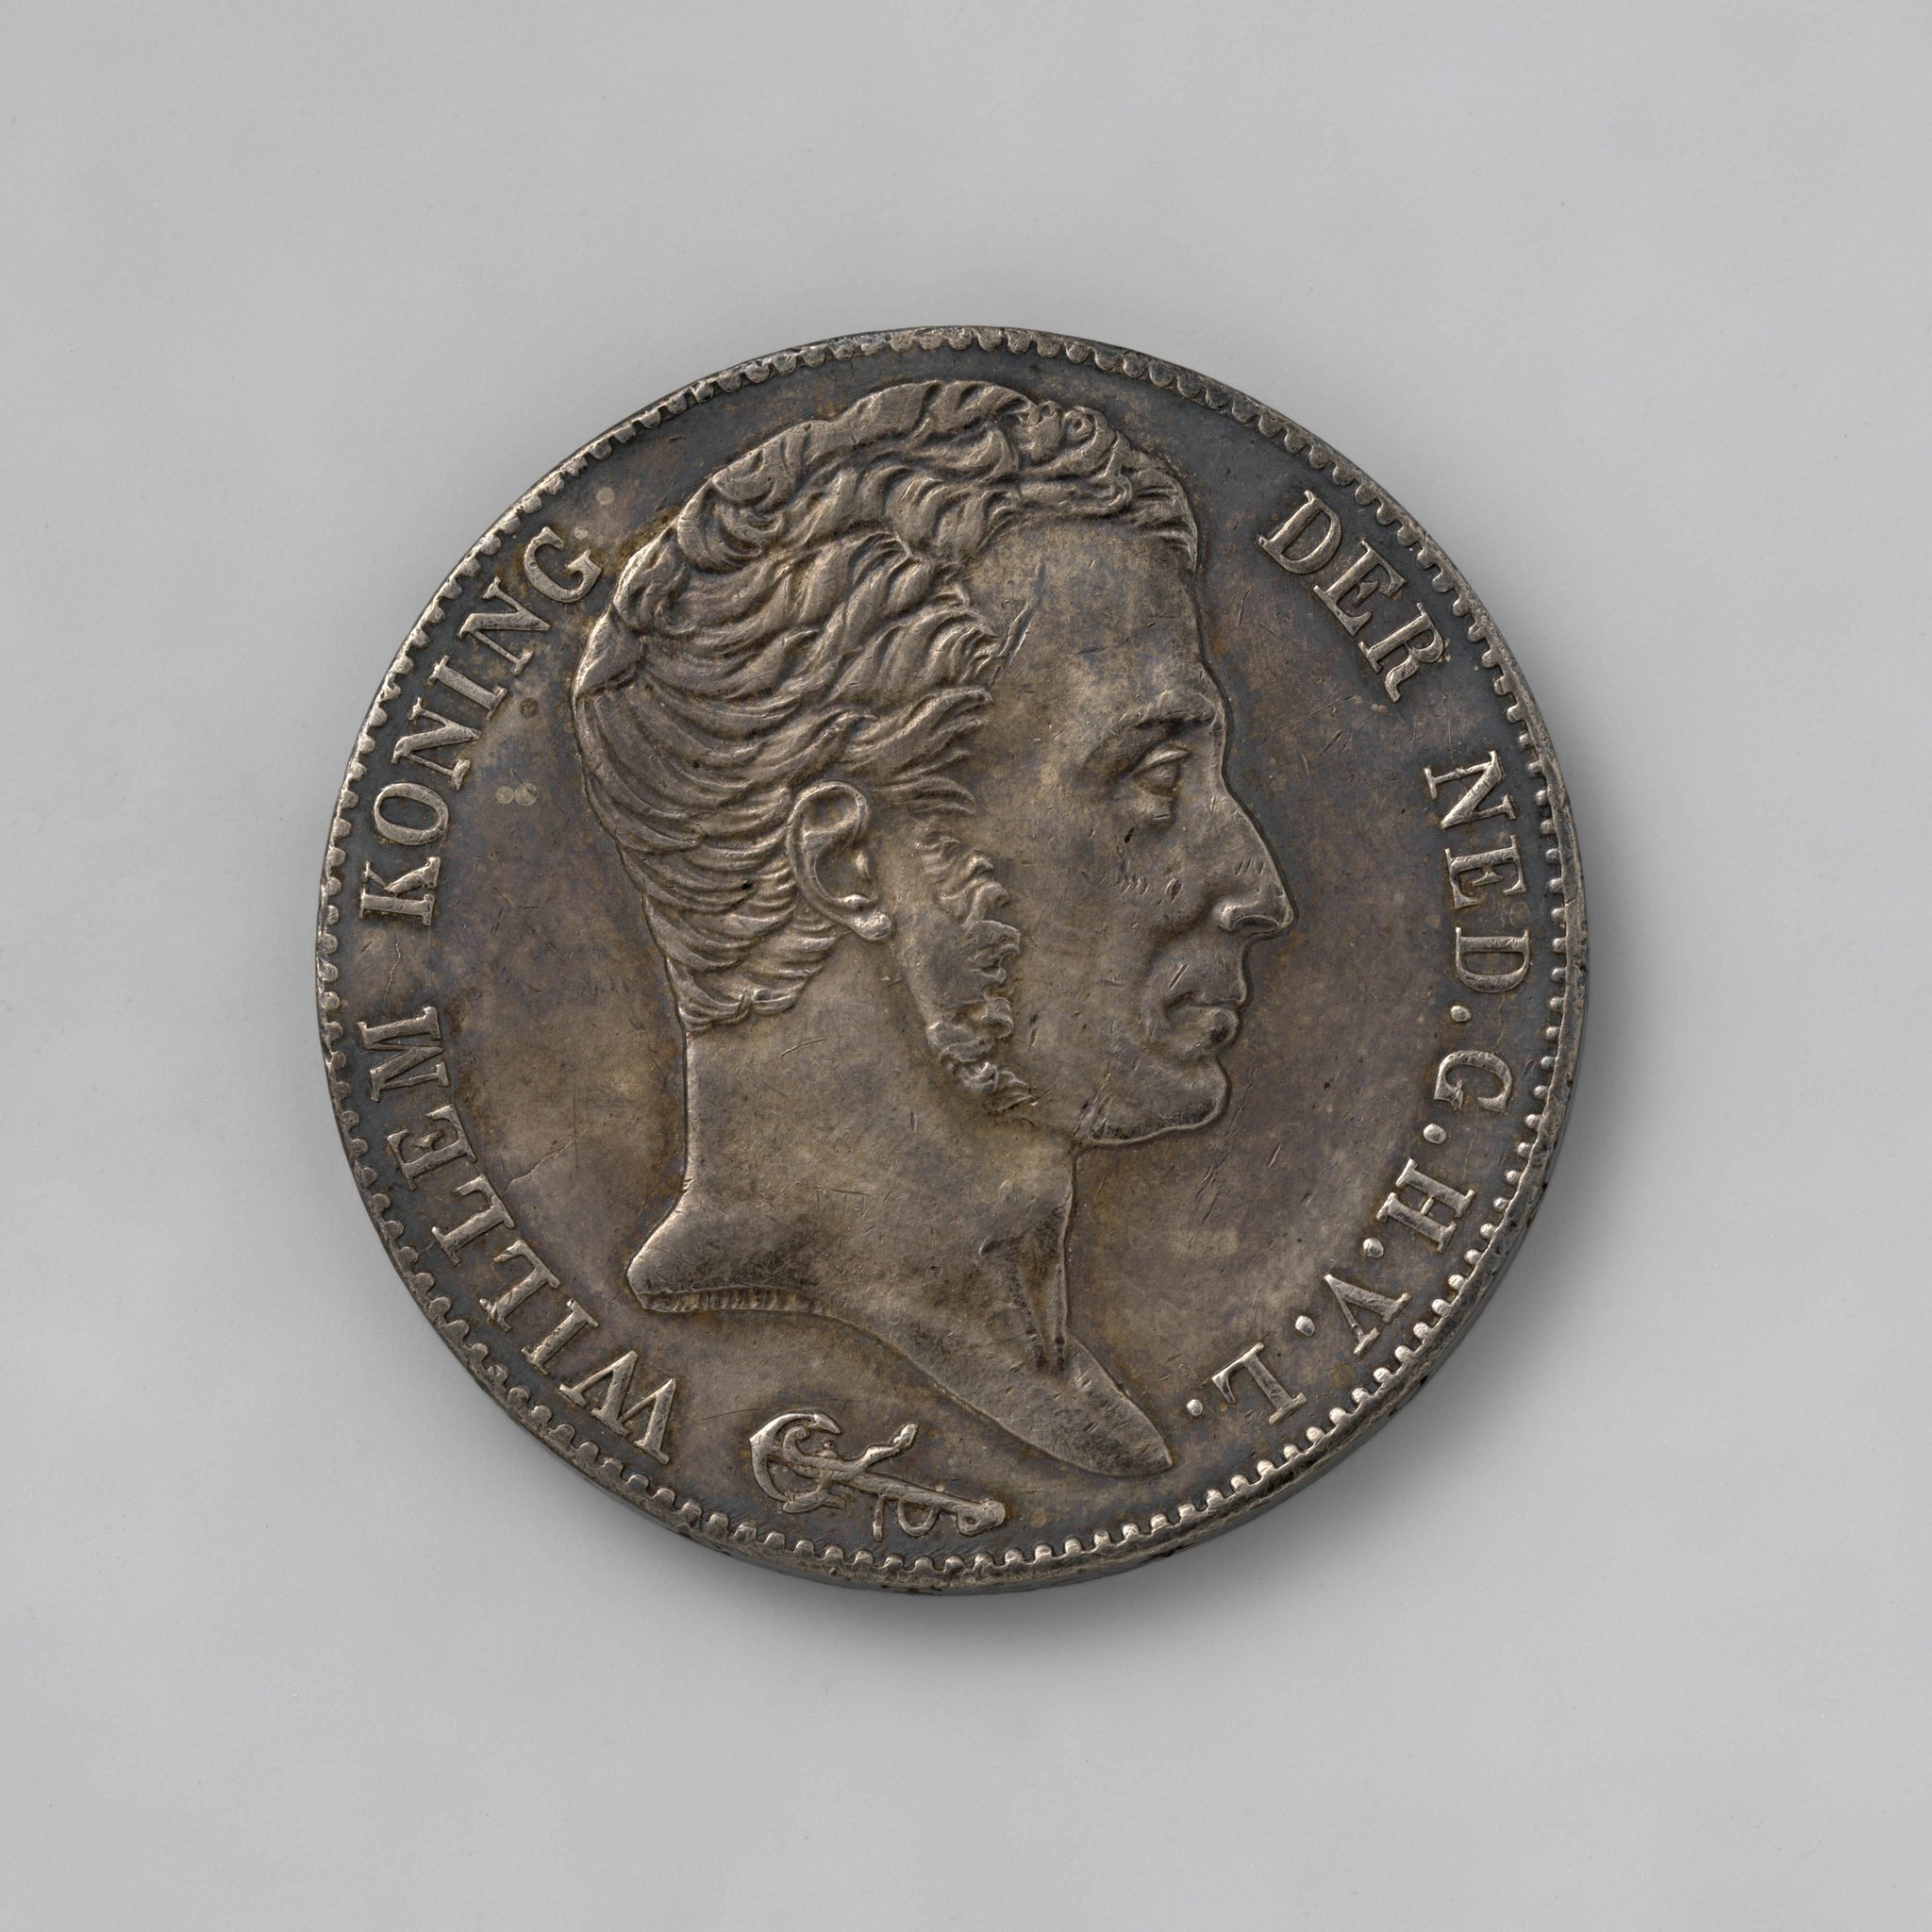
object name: coin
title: Nederlandse 3 gulden, 1832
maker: william i of the netherlands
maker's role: koning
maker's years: 1772-1843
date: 1832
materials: silver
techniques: striking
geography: utrecht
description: Zilveren munt. Voorzijde: borstbeeld naar rechts. Keerzijde: tussen waarde-aanduiding 3 G gekroond rijkswapenschild. Jaartal boven kroon. Randschrift.